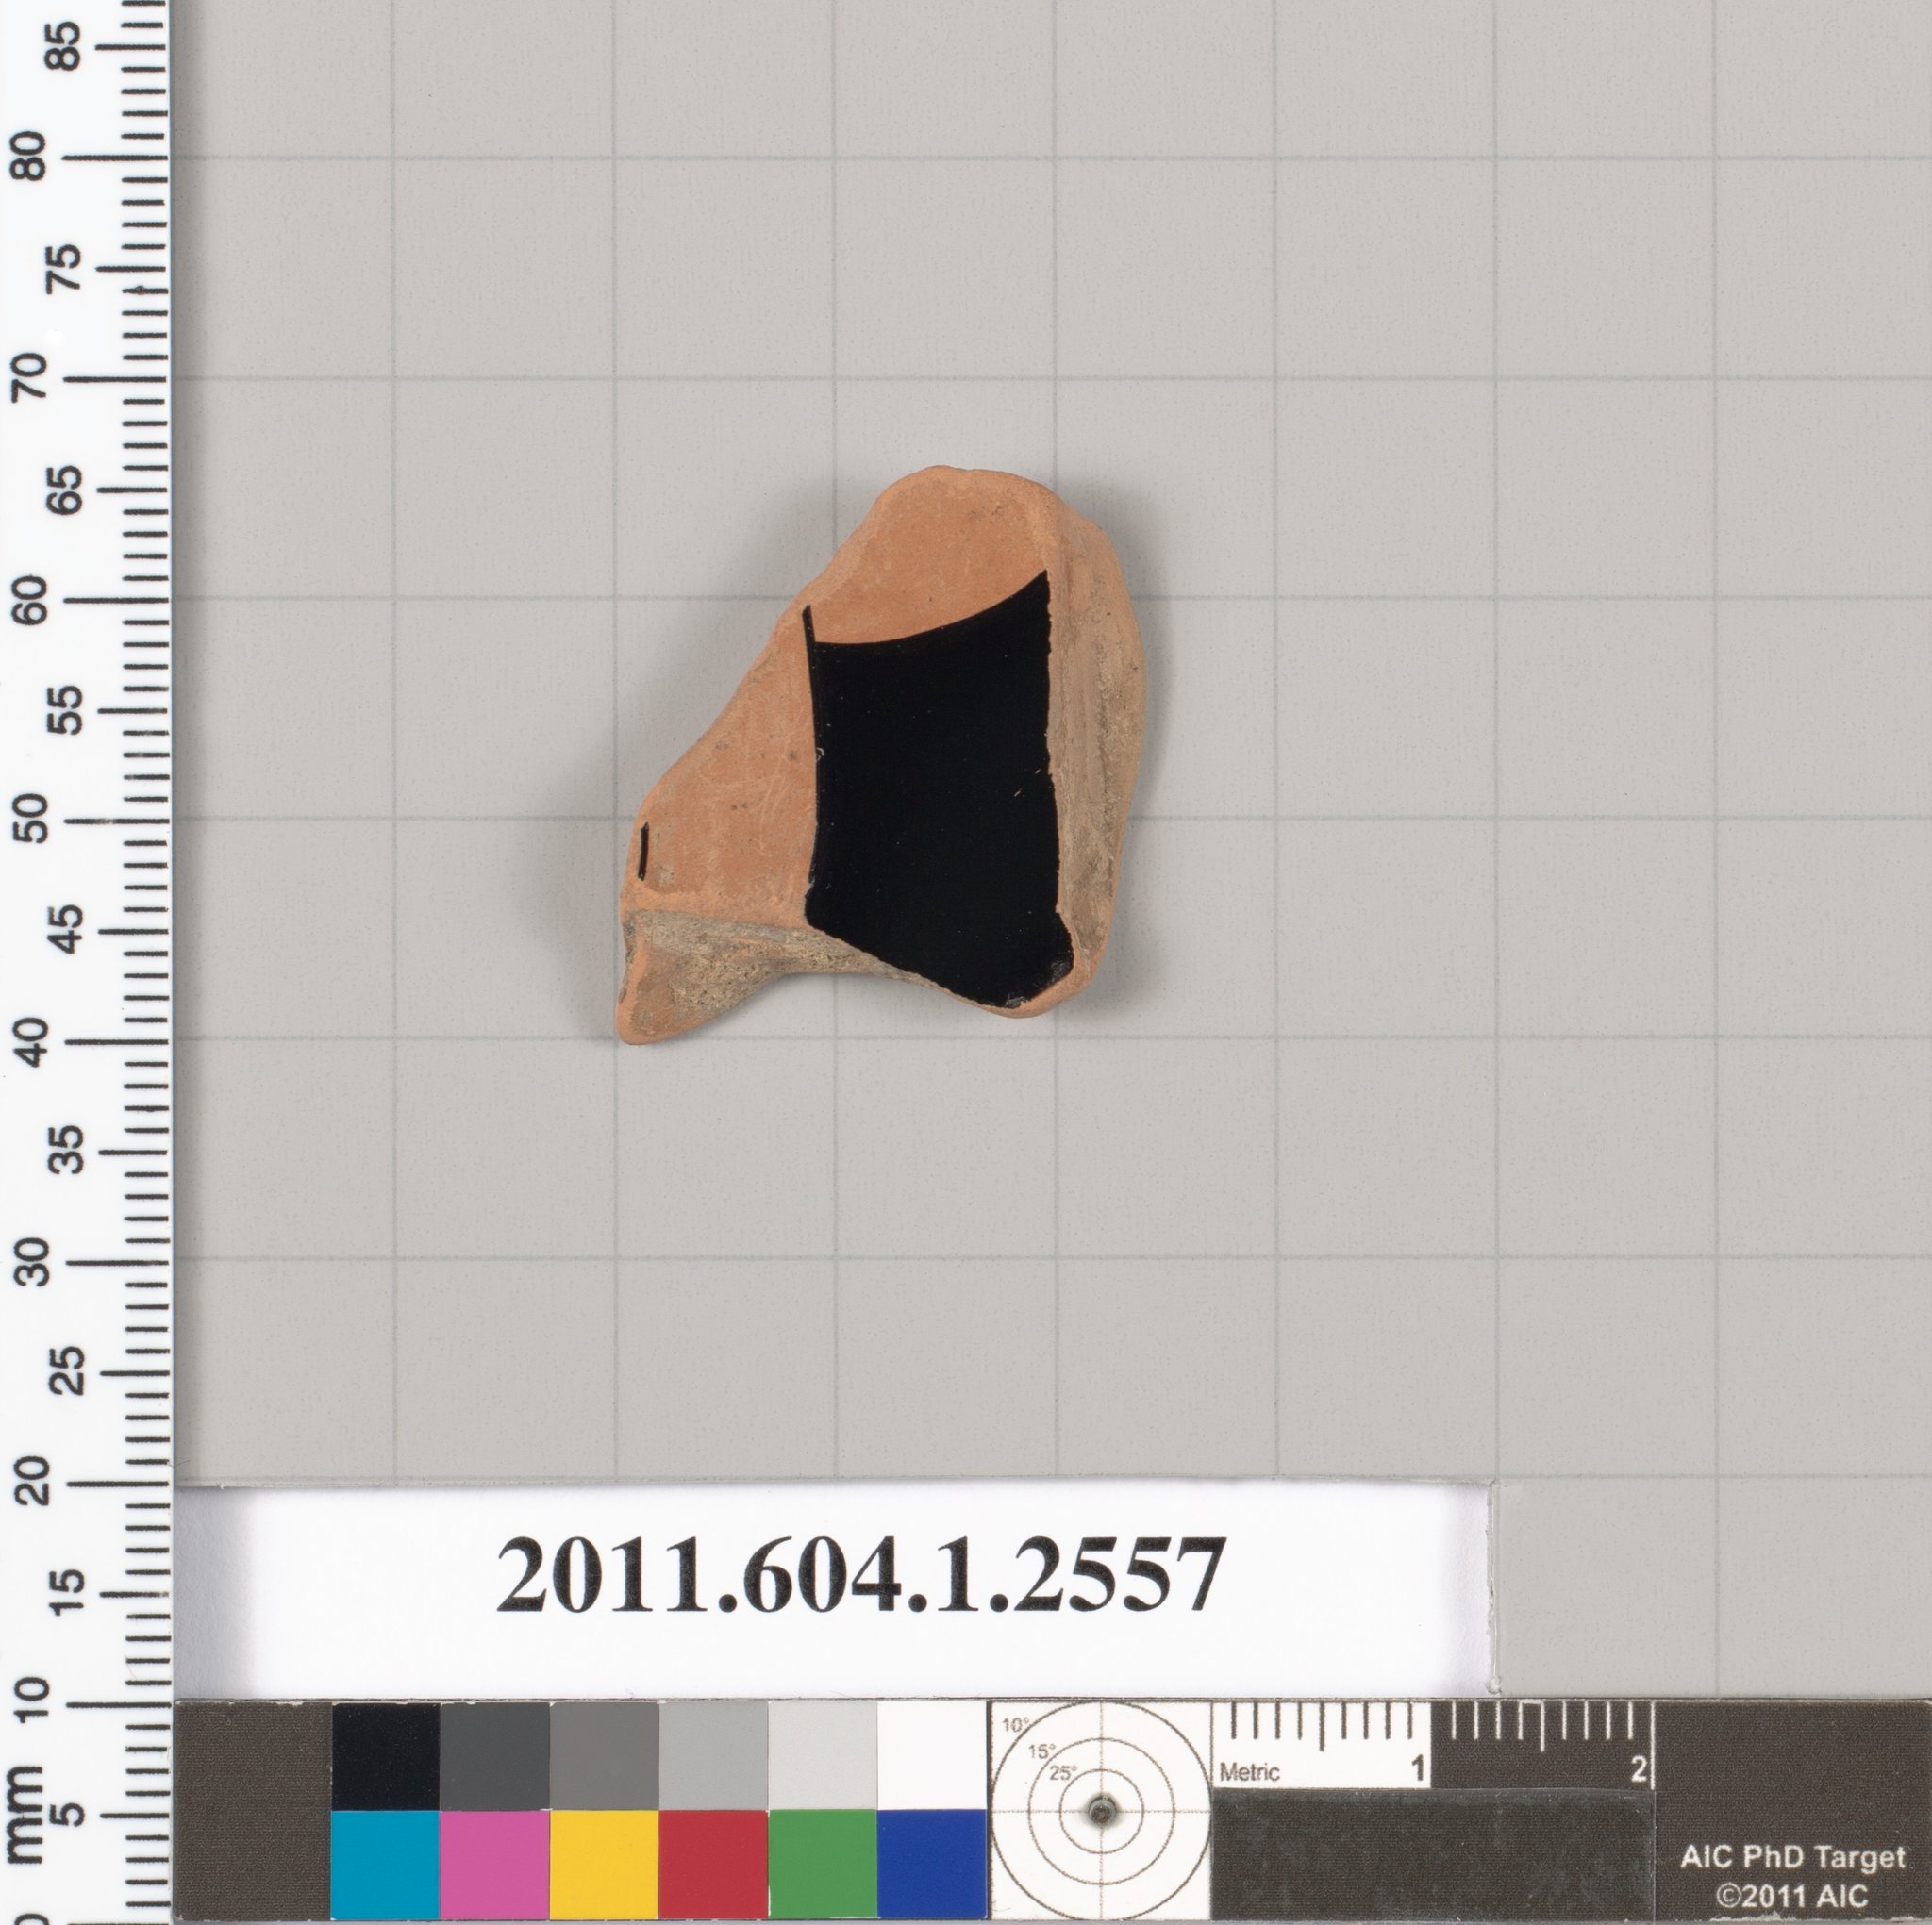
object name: kylix fragment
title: Terracotta fragment of a kylix (drinking cup)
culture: greek, attic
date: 500-451 BCE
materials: terracotta